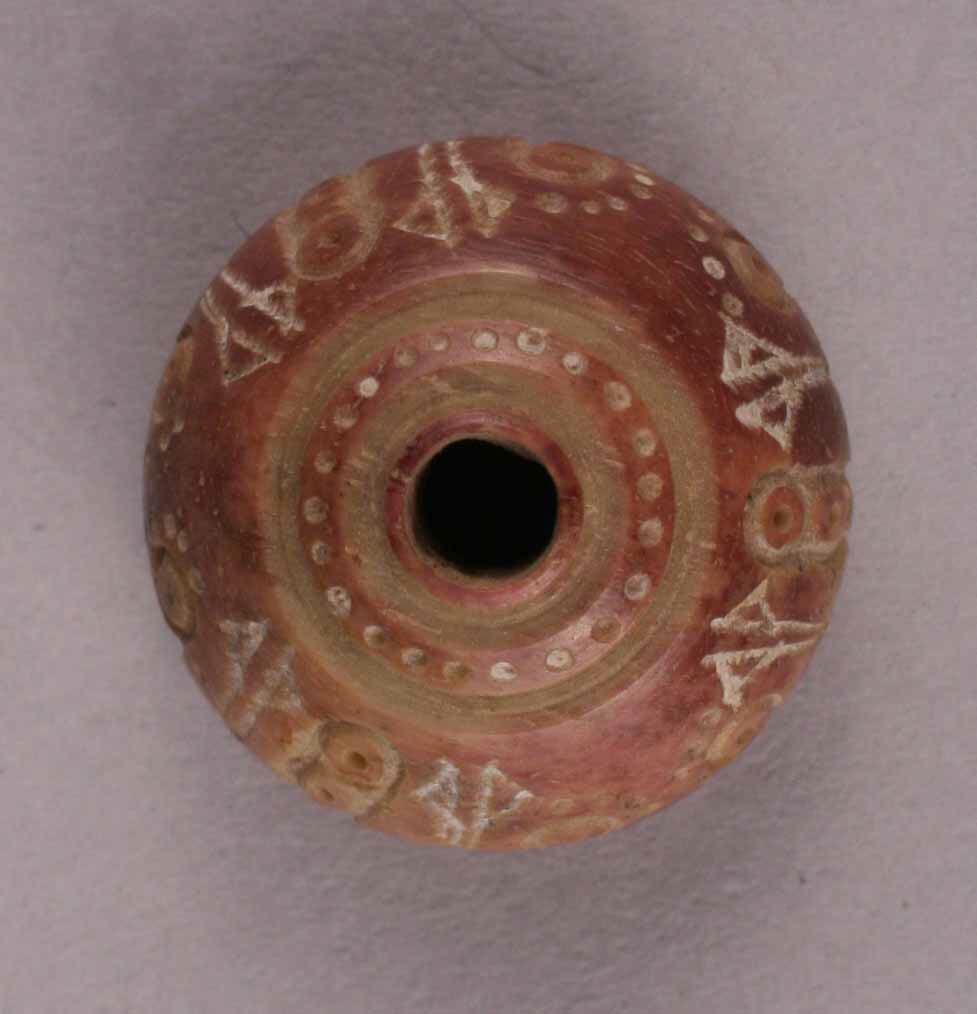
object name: spindle whorl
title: Button or Bead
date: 801-1000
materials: bone, paint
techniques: incising, inlay, tinting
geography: iran